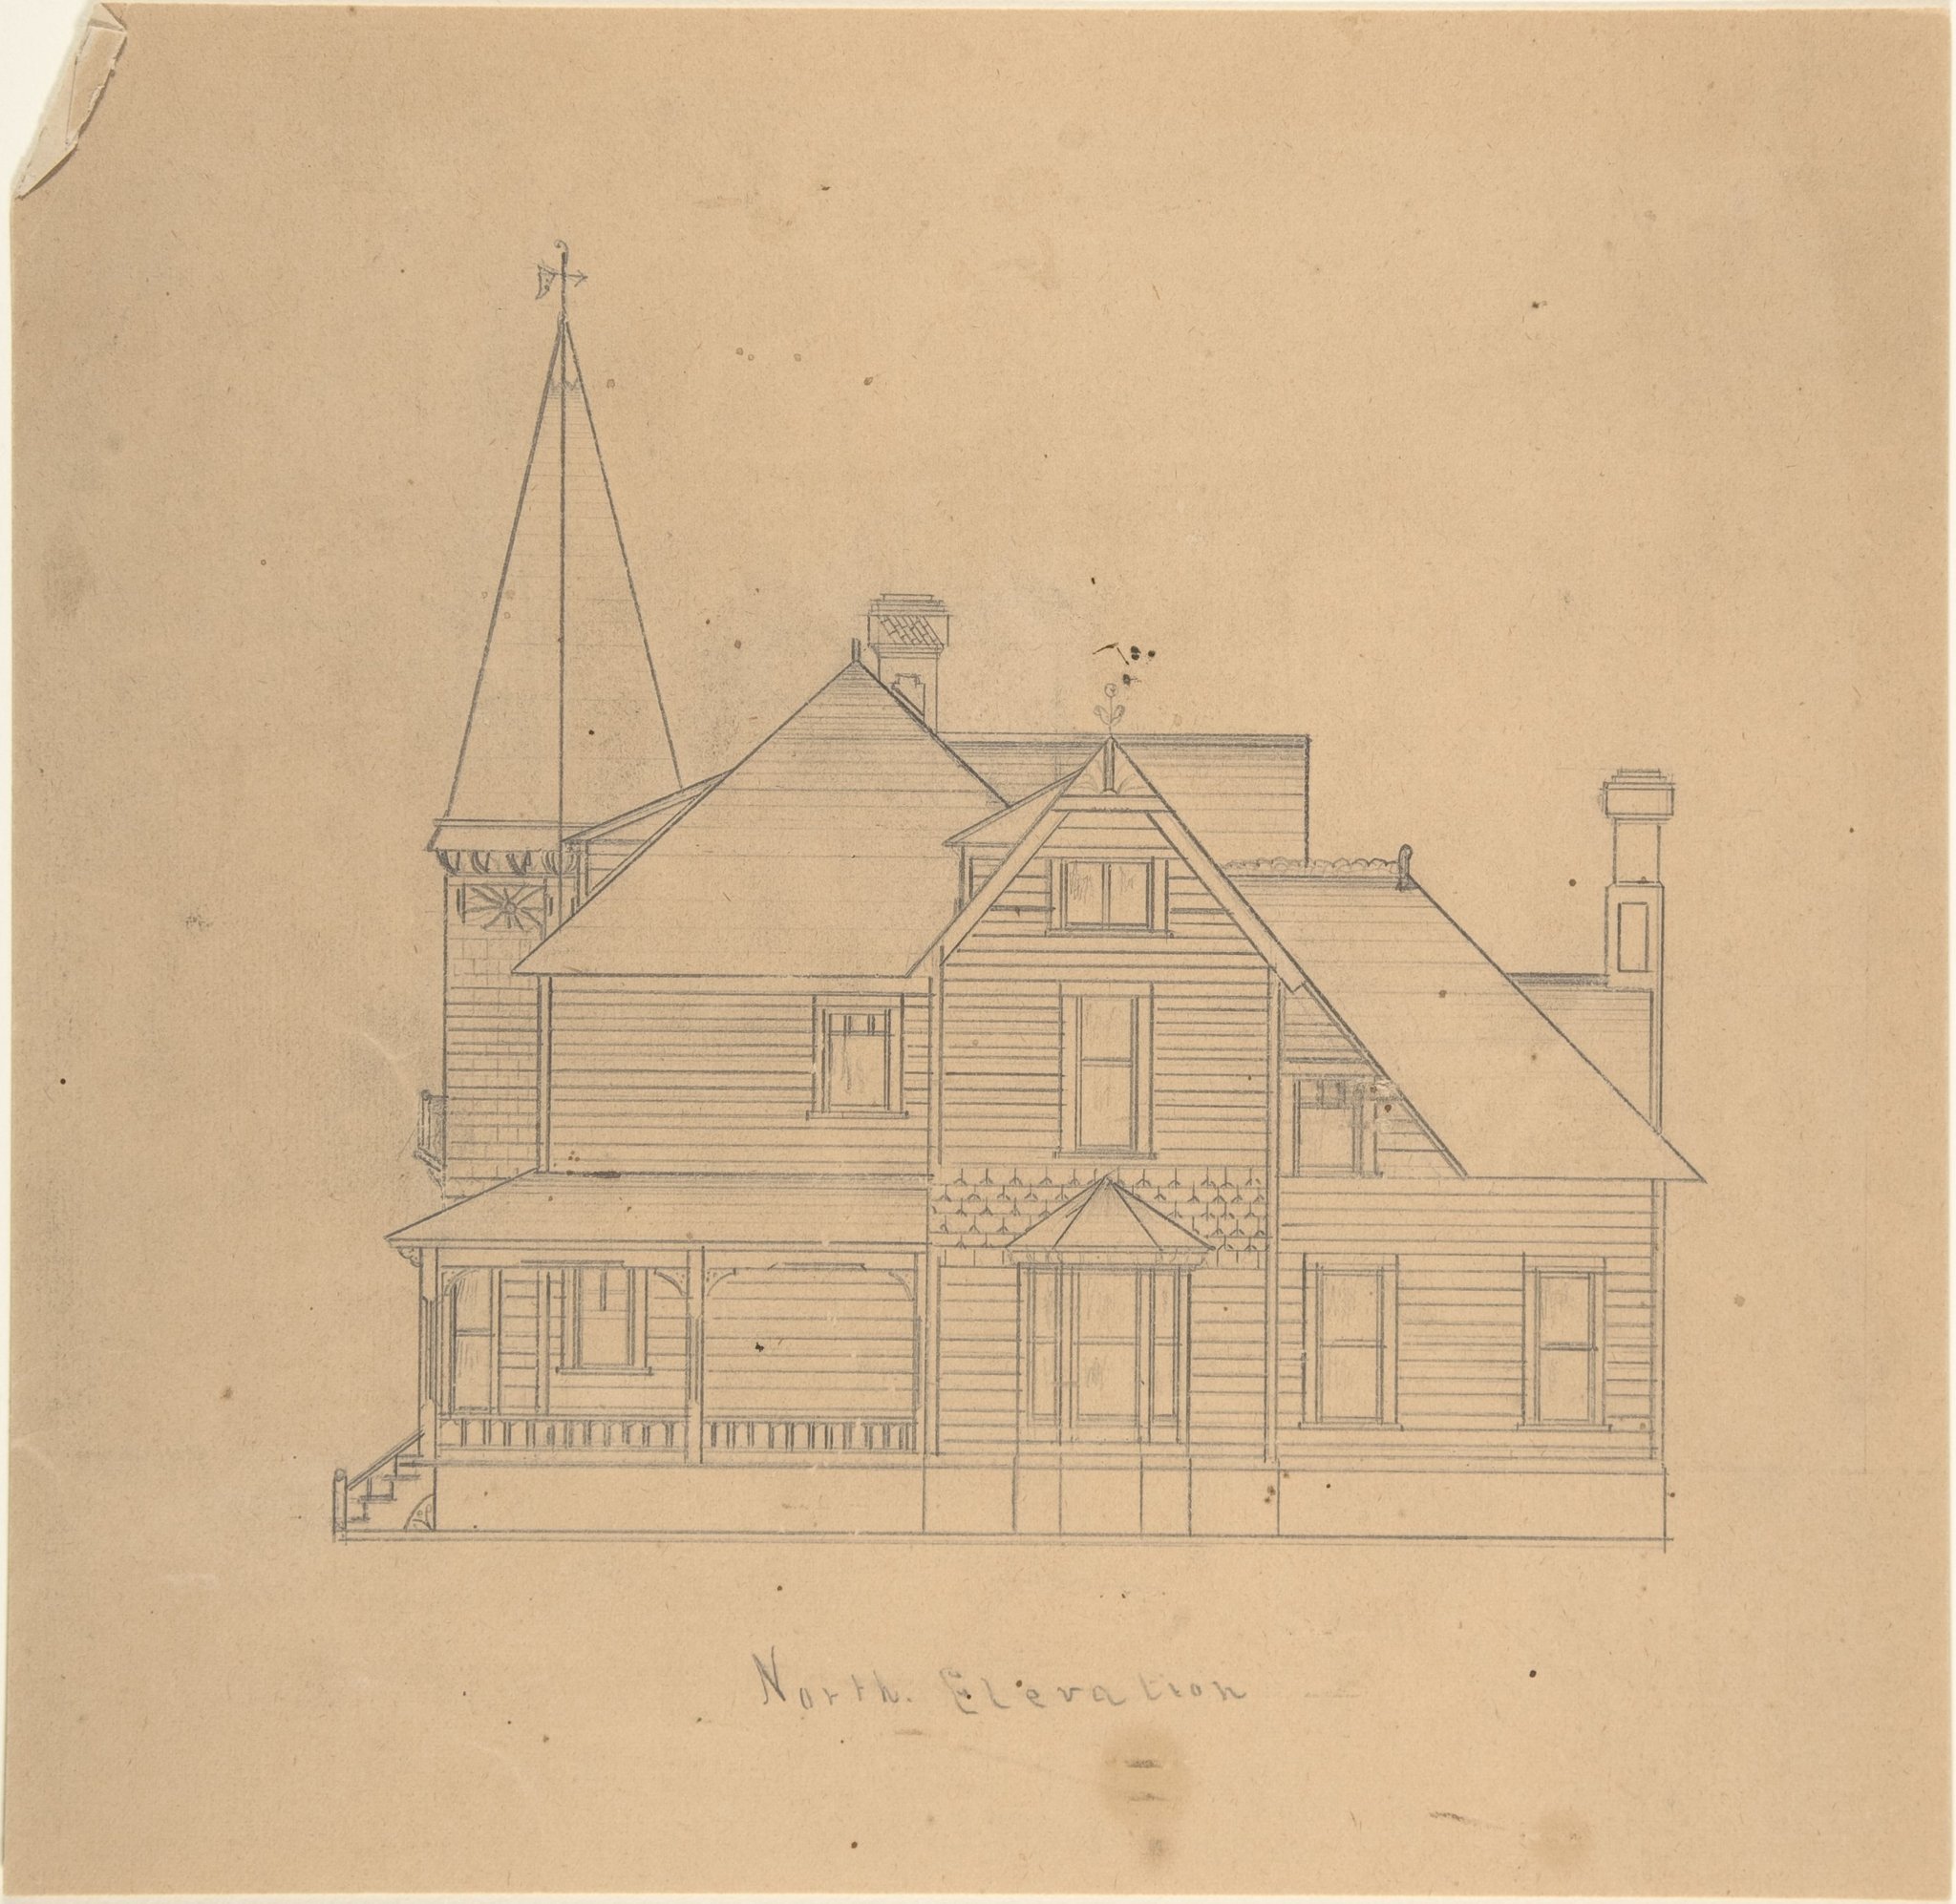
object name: drawing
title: Design for a House, North Elevation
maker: w. strong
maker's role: artist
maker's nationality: british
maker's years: 19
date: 1883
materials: graphite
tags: architecture